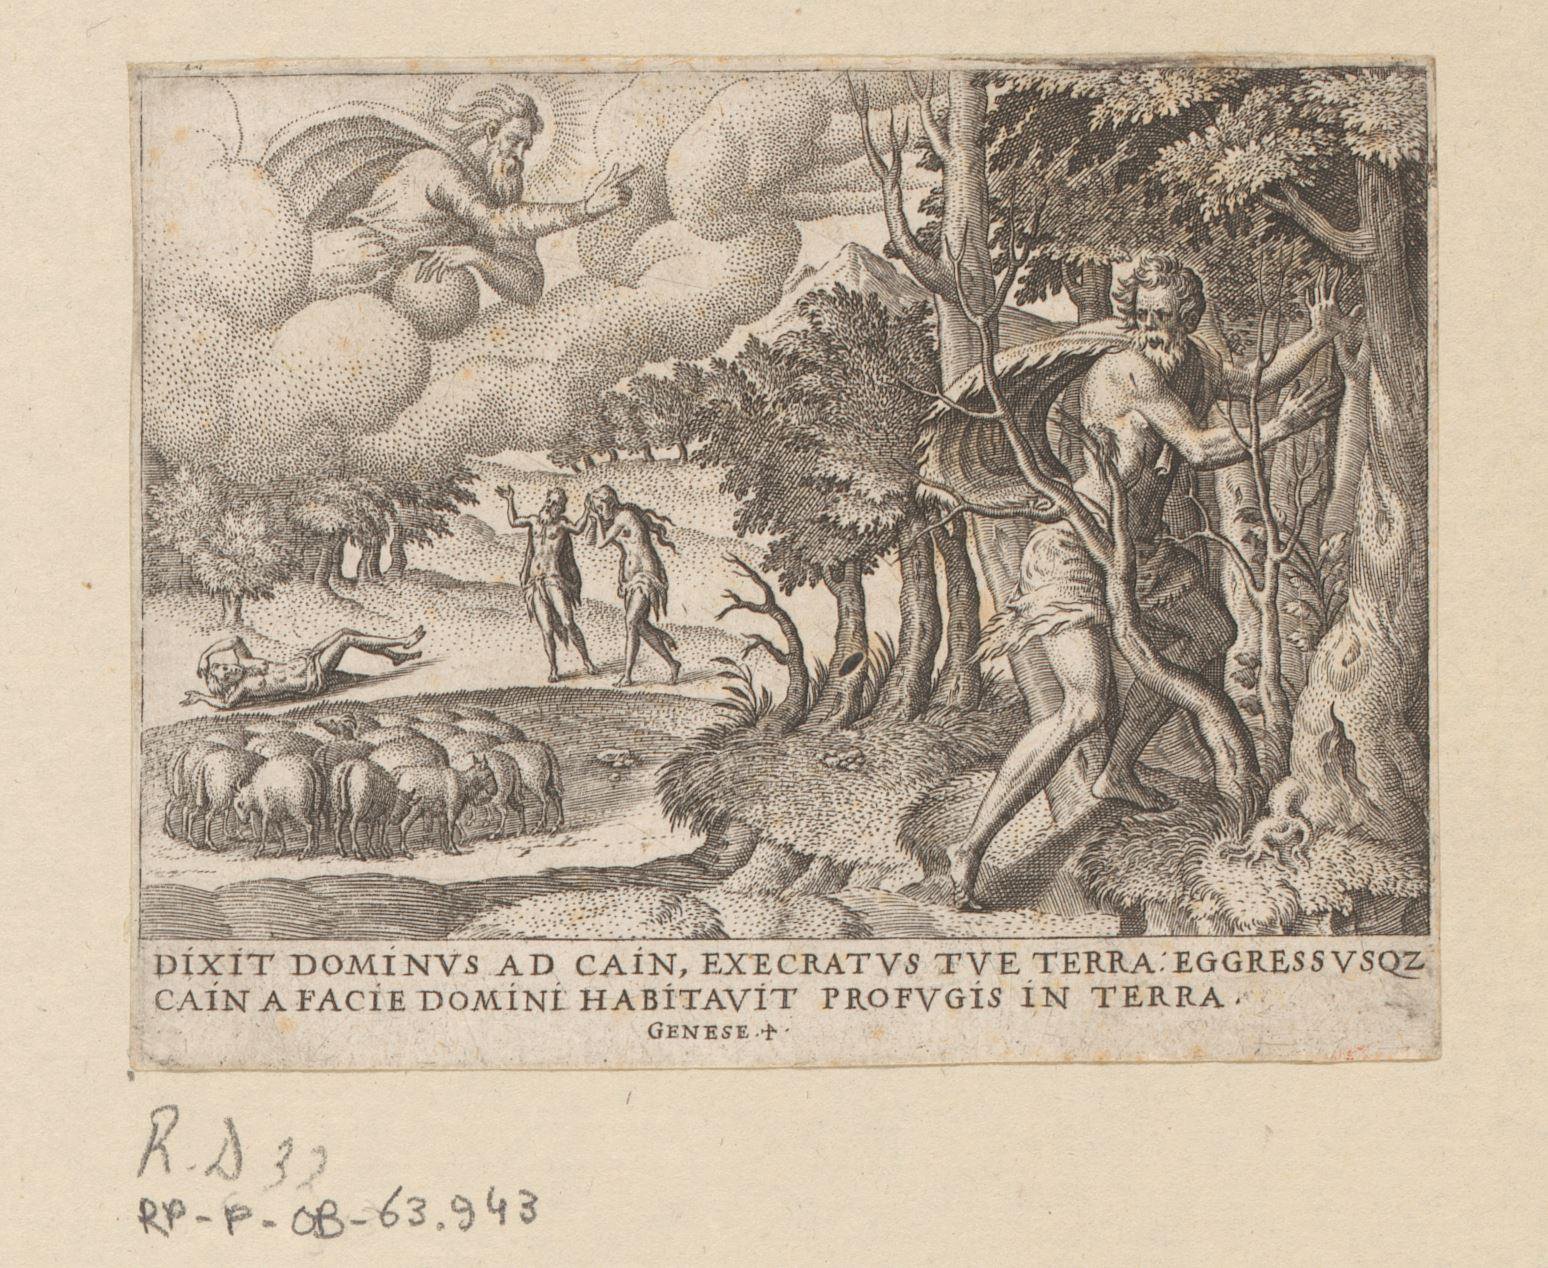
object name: print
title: God vervloekt Kaïn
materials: paper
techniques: engraving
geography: france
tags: adam and eve discover the dead body of abel and grieve over it, the lord calls on cain to account for his deed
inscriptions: collector's mark: Lugt 240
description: God verschijnt aan Kaïn en vervloekt hem omdat hij zijn broer heeft vermoord. Op de achtergrond links vinden Adam en Eva het lijk van Abel.